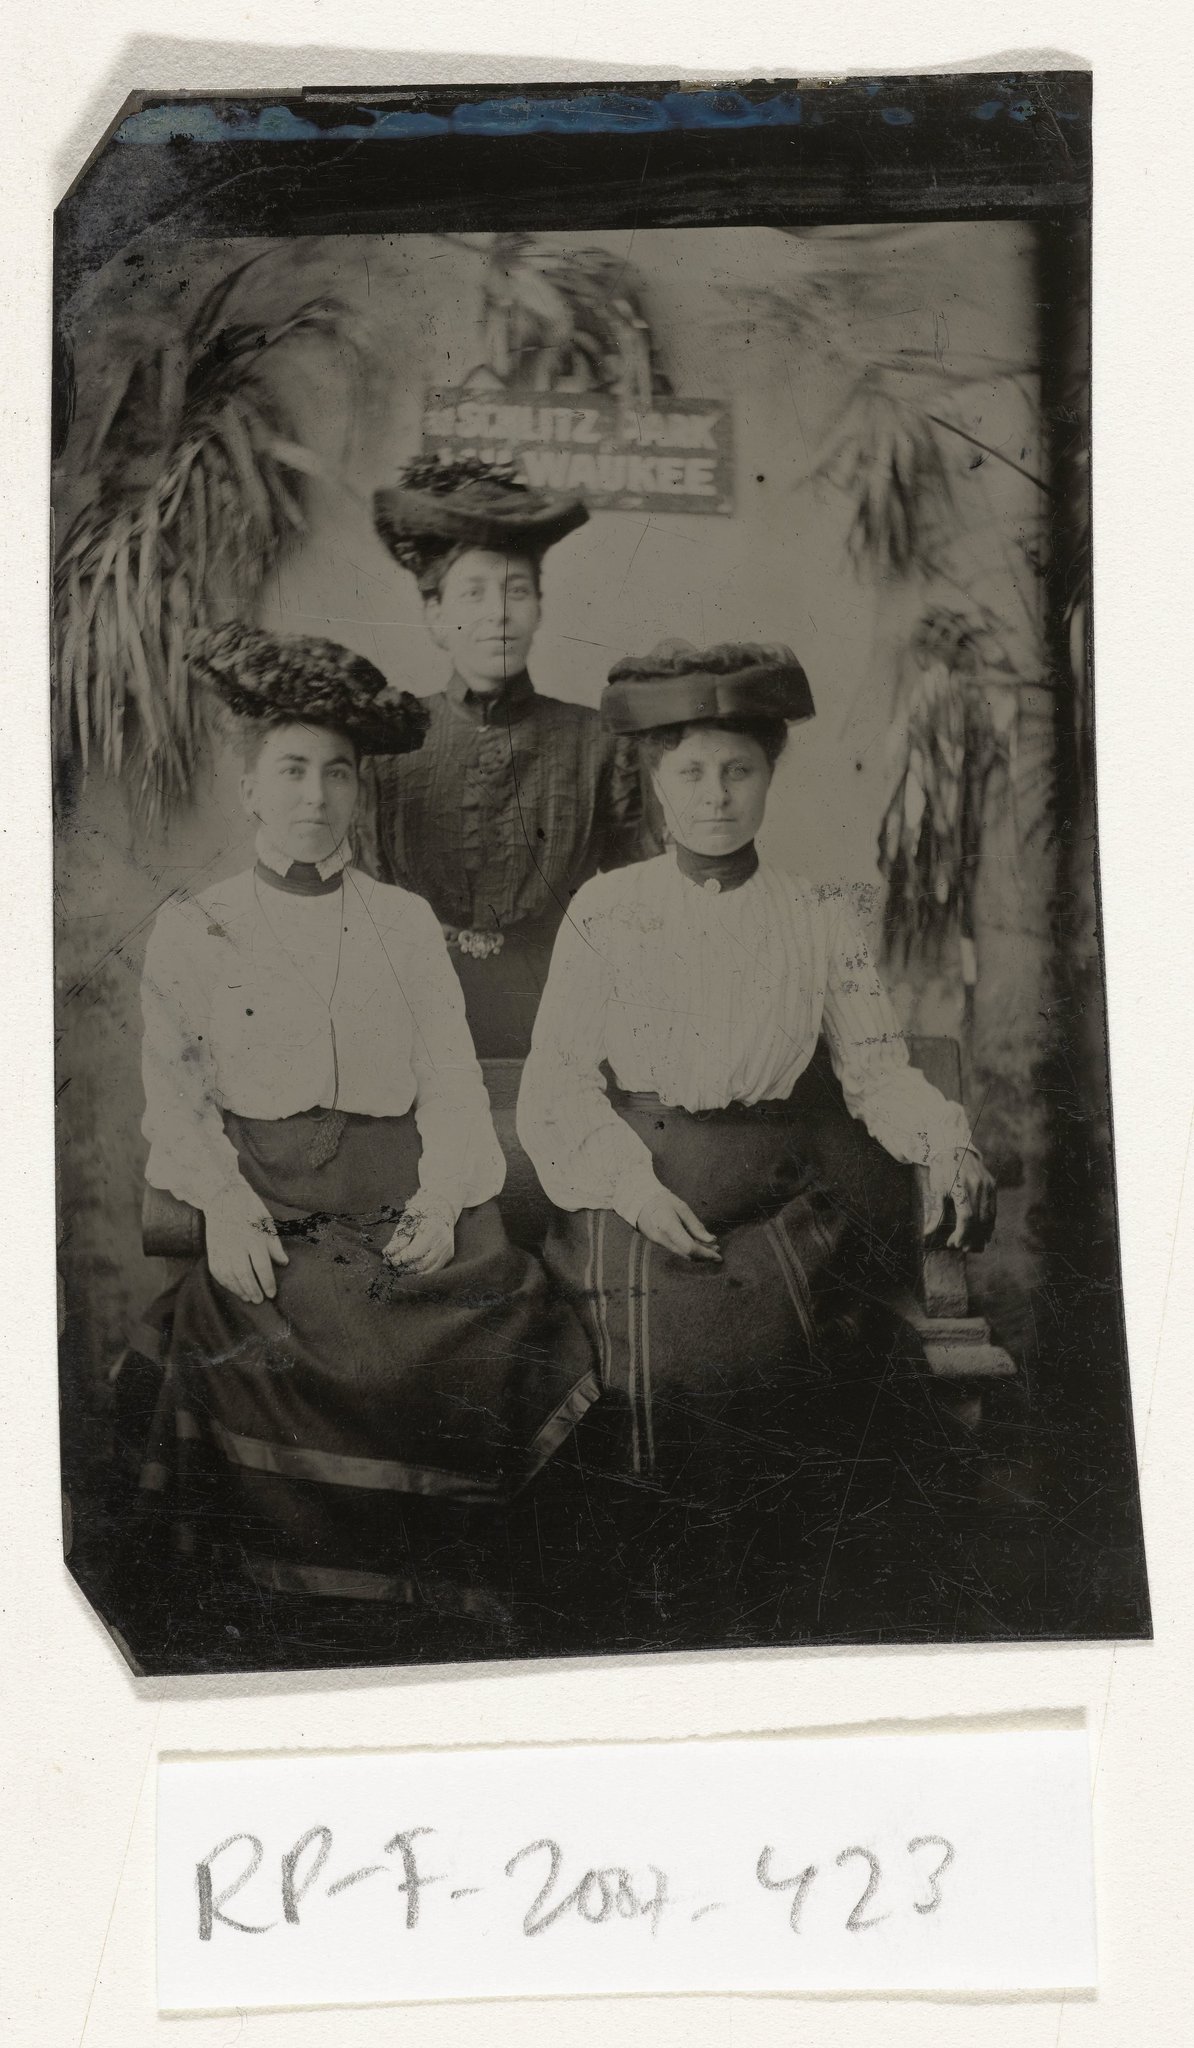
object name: photograph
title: Portret van drie vrouwen, staand en zittend in een studiodecor, met achter hen een bordje met de tekst 'AT SCHLITZ PARK / MILWAUKEE', Milwaukee, Wisconsin, Verenigde Staten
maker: Anonymous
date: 1880-1910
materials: metal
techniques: ferrotyping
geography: united states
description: Schlitz Park behoorde (?) tot de Joseph Schlitz Brewing Company